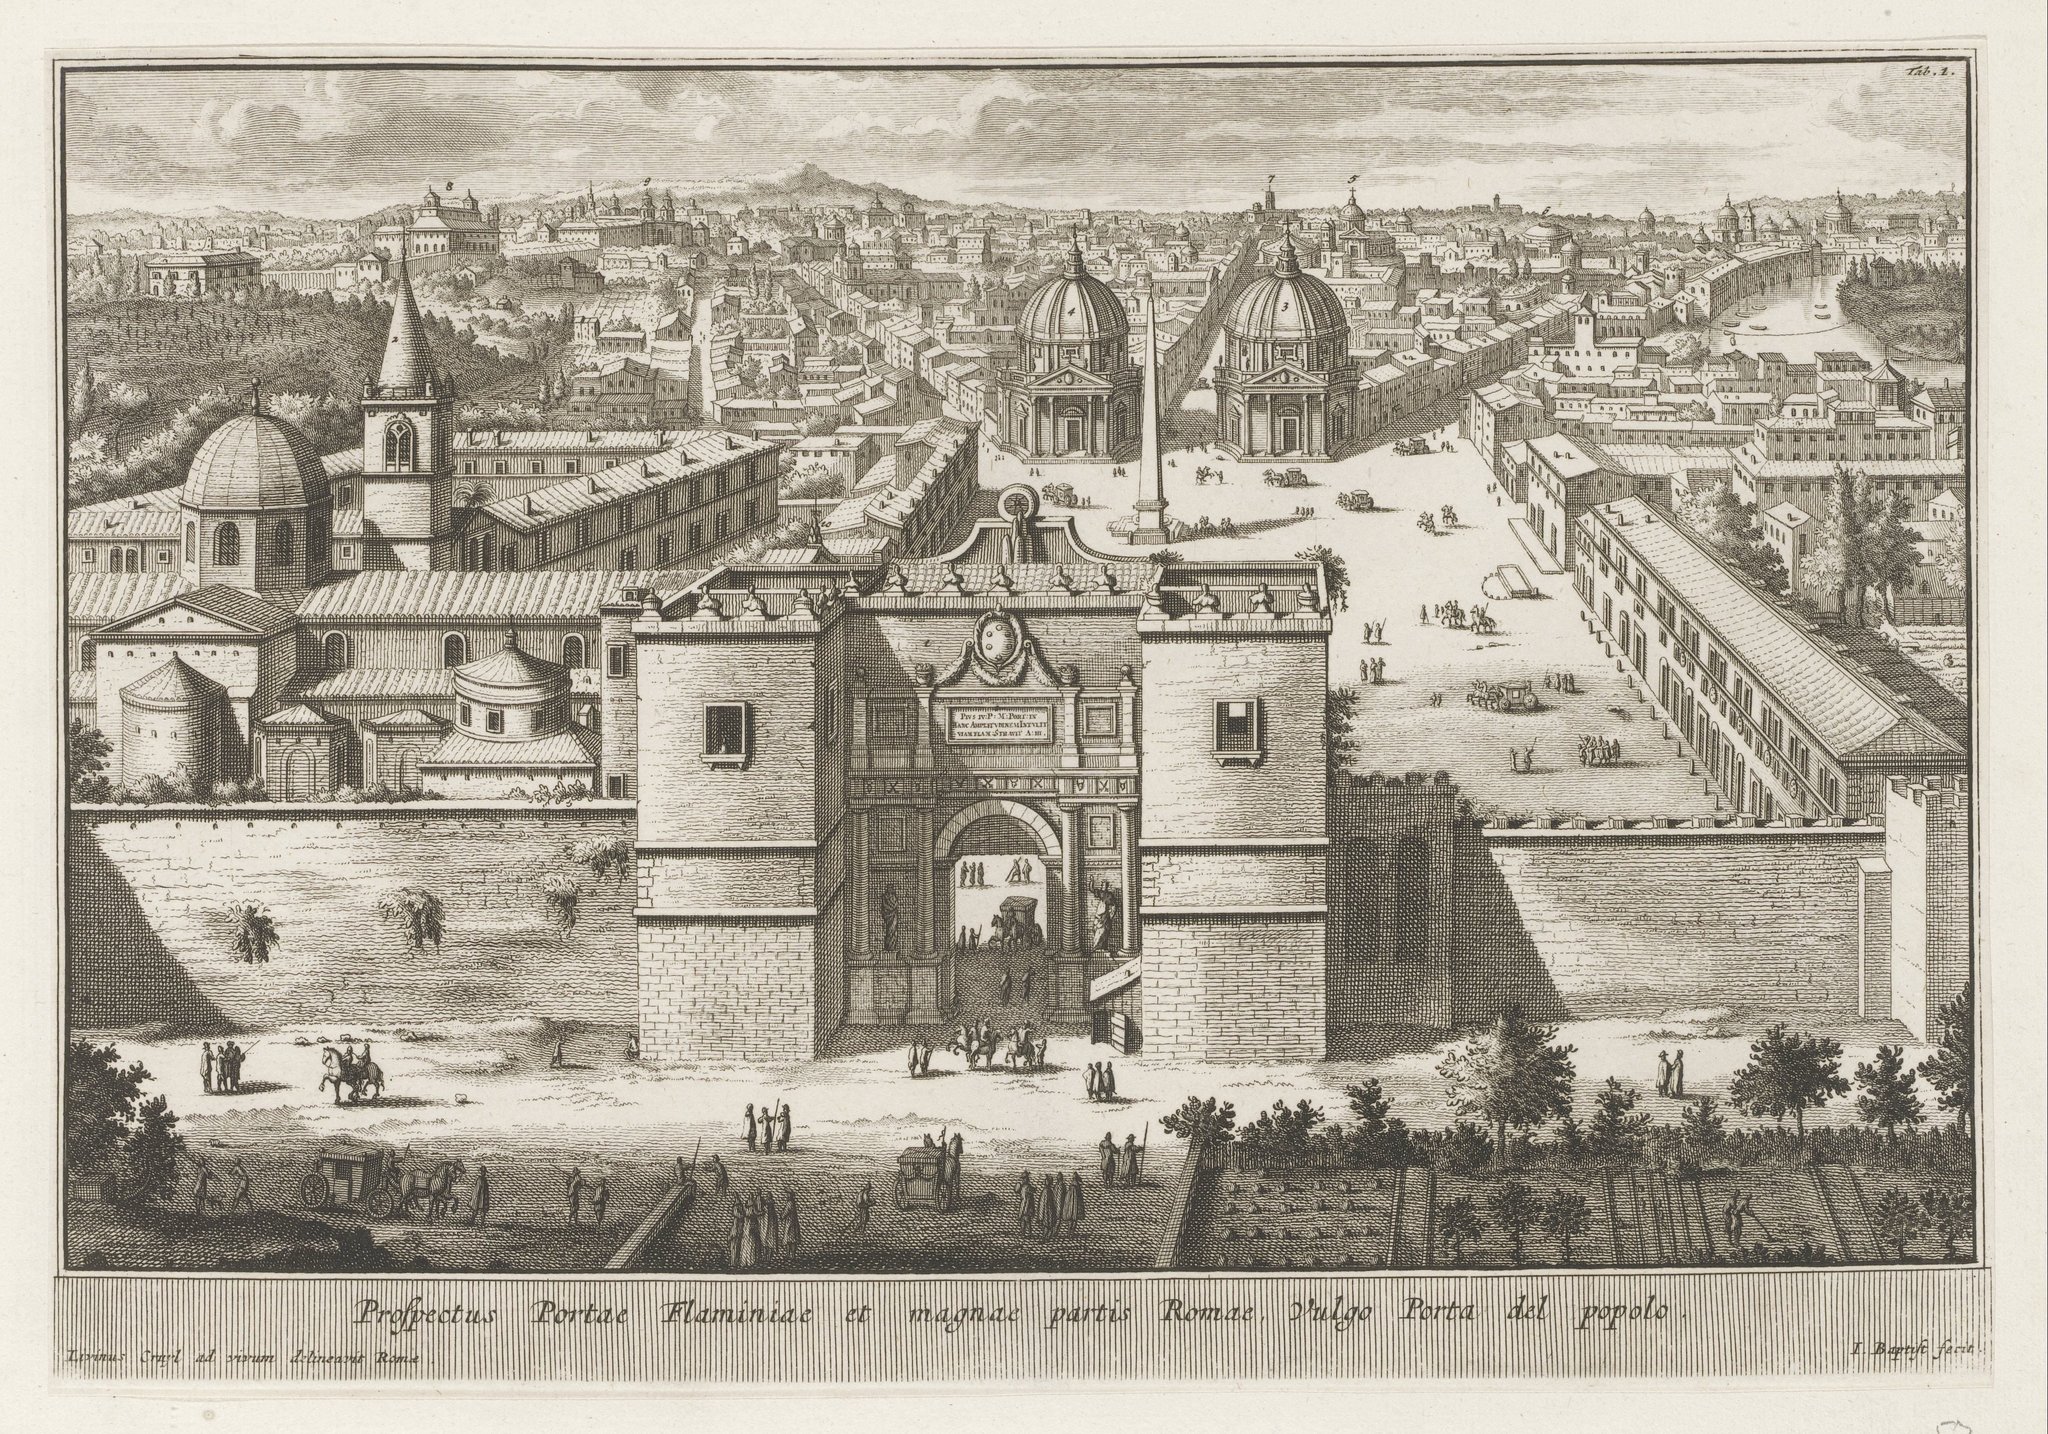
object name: album leaf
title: Piazza del Popolo te Rome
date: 1729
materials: paper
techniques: etching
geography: leiden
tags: square, place, circus, etc., city-view, and landscape with man-made constructions, church (exterior), city-gate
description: Gezicht op Piazza del Popolo en de Porta del Popolo te Rome. Op het plein staat de Egyptische obelisk van Ramses II. Aan het einde van het plein staan de tweelingkerken de Santa Maria dei Miracoli en de Santa Maria in Montesanto. De prent maakt deel uit van een album.